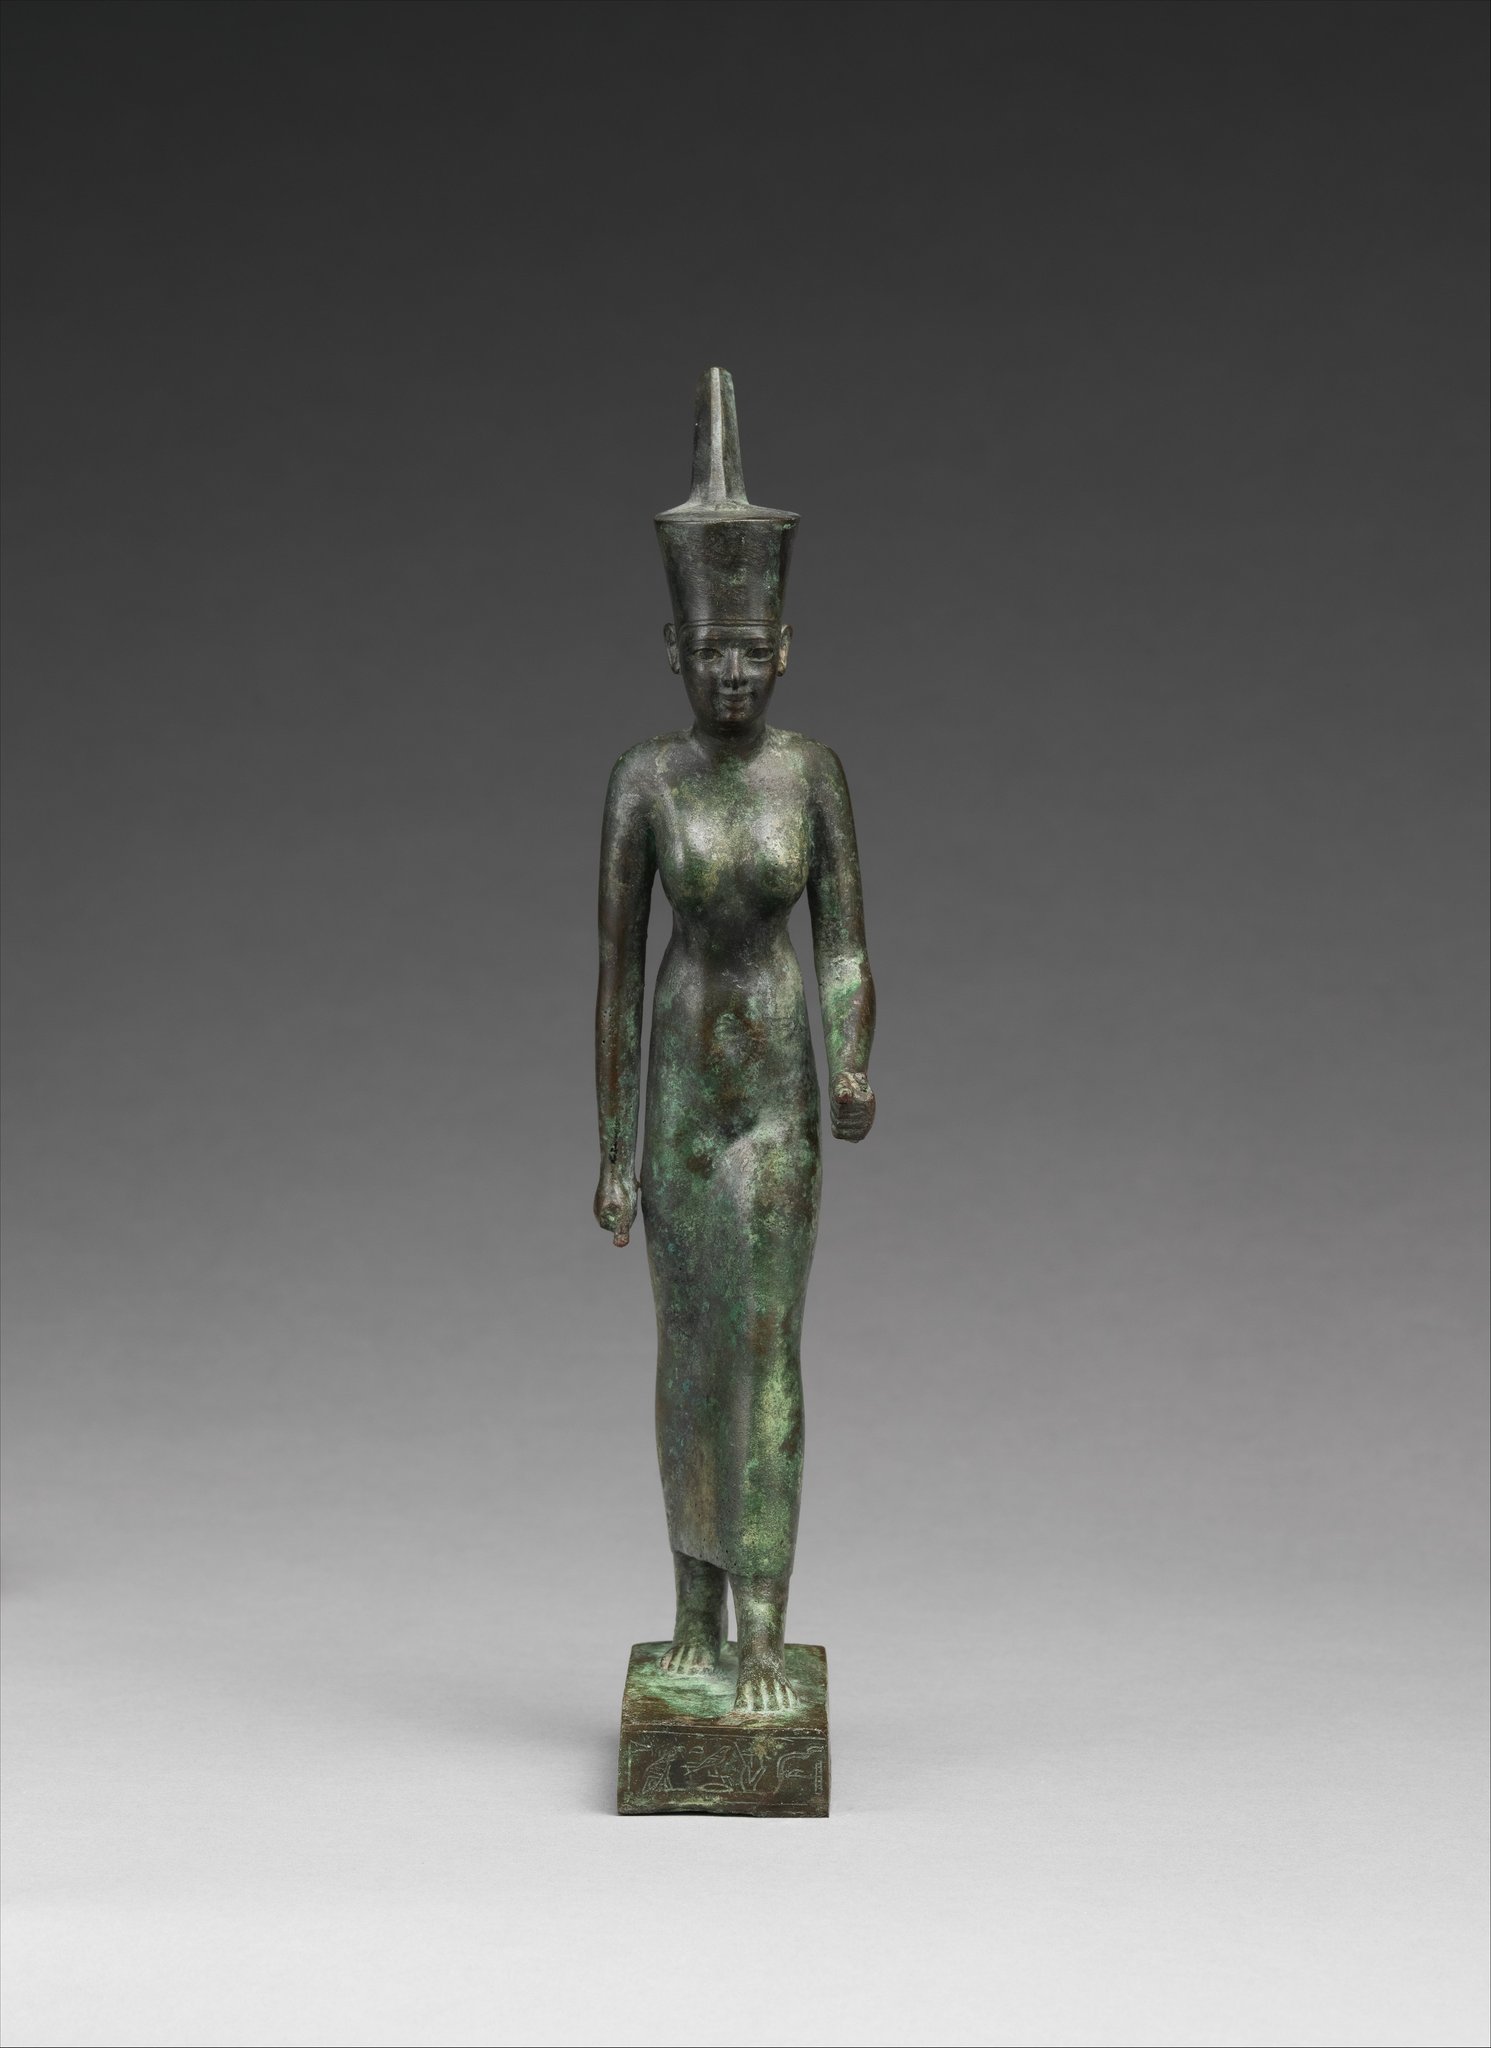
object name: statuette, neit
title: Statuette of the goddess Neit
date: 664-525 BCE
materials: metal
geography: egypt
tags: goddess